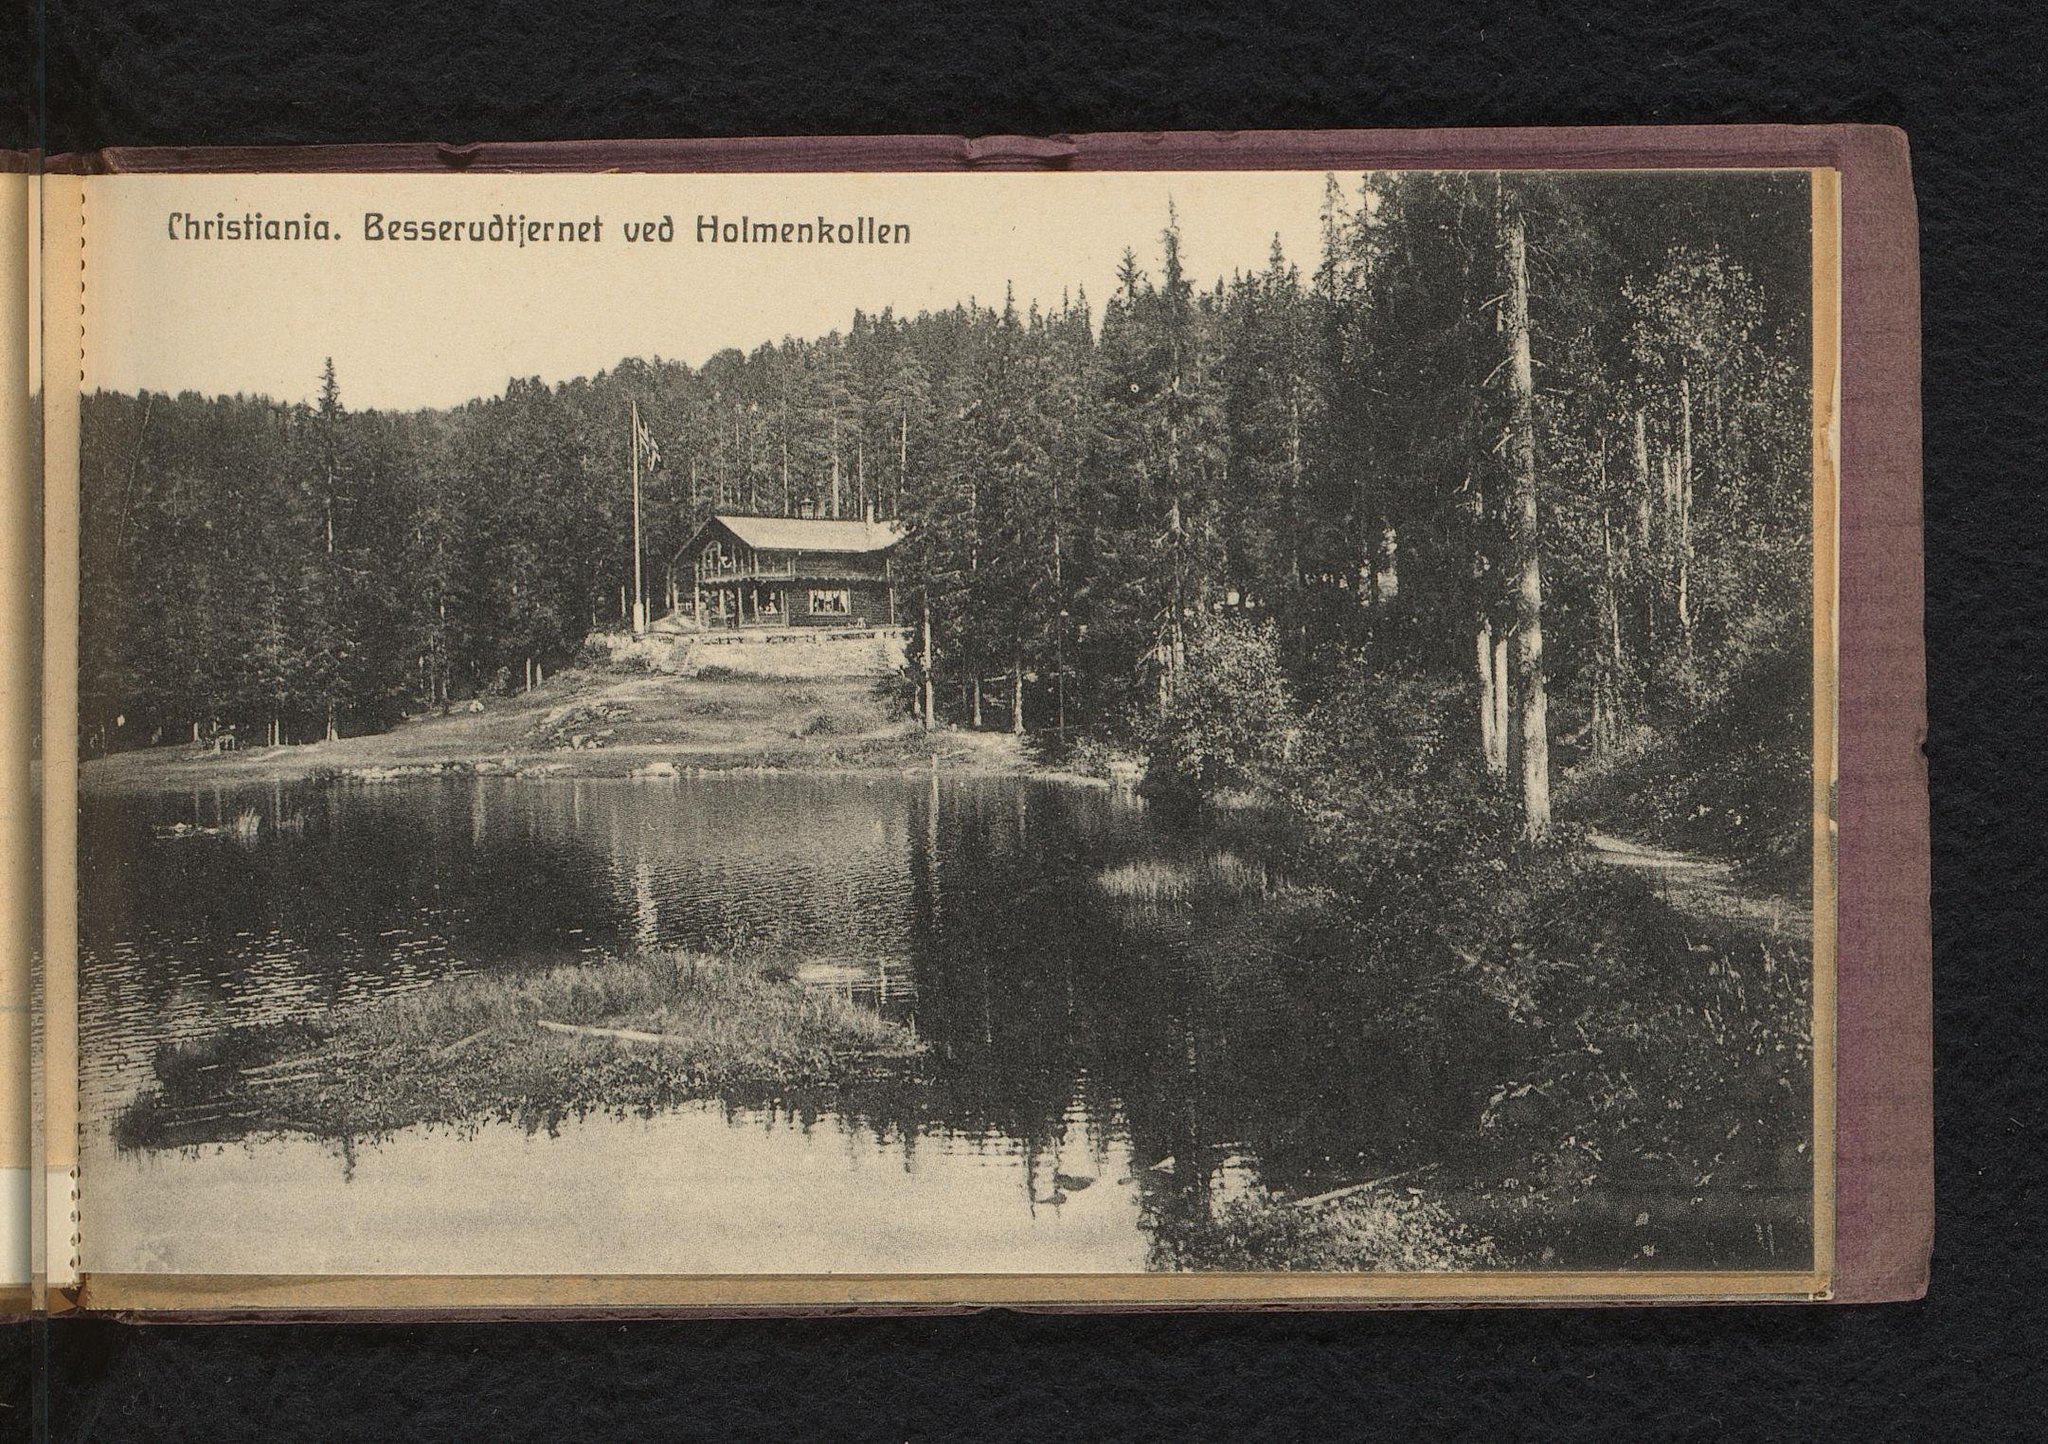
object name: photomechanical print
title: Christiania. Besserudtjernet ved Holmenkollen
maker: Anonymous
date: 1904-1925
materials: cardboard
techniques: photograph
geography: oslo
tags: rural housing, e.g. country-house, villa, cottage, pond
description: Prentbriefkaart maakt deel uit van een album.